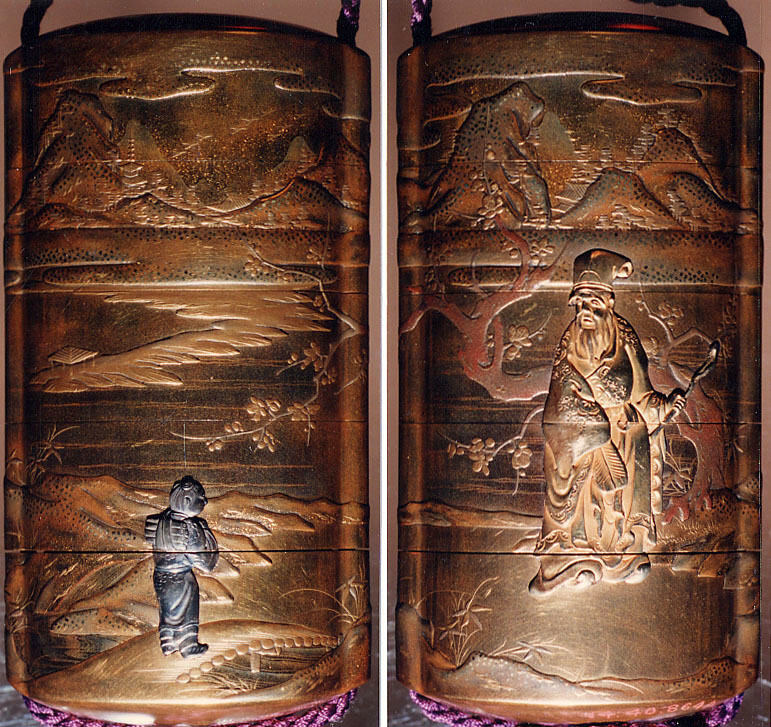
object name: inrō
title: Case (Inrō) with Design of God of Longevity (Jurōjin) beside Flowering Plum Tree (obverse); Karako Walking on Bridge (reverse)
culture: japanese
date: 1801-1900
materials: gold, lacquer, metal, silver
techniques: fundame, hiramakie, inlay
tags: bridges,men,trees,gods